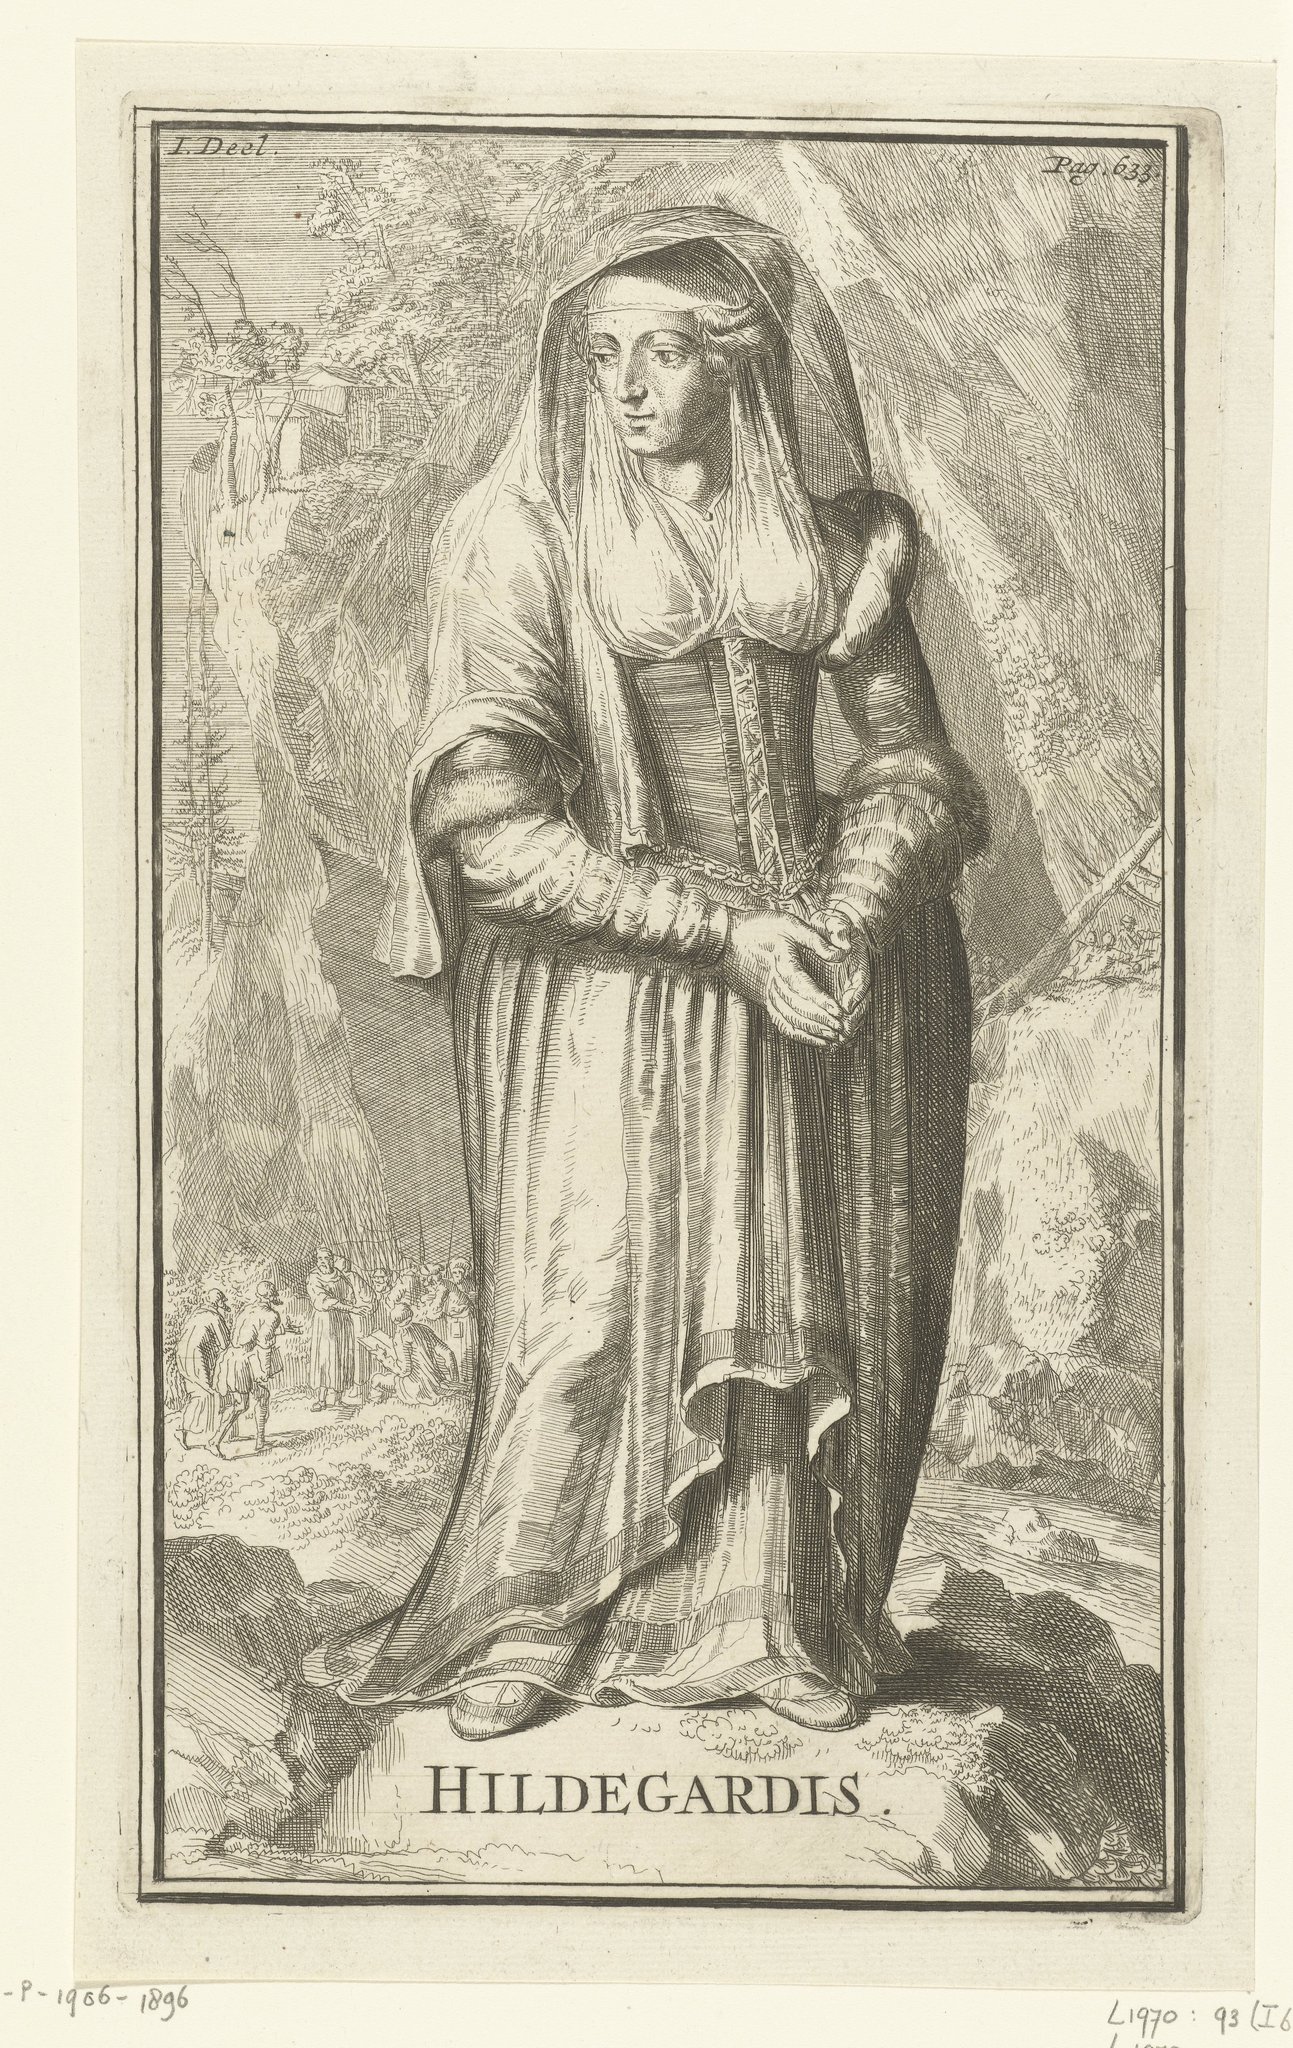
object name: print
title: Historie der Kerken en ketteren (...) tot aan het jaar onses Heeren 1688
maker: romeyn de hooghe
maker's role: draughtsman, goldsmith, painter, print maker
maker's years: 1645-1708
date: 1701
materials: paper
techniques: engraving, etching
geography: netherlands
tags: hildegard van bingen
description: Blad uit: Godfried Arnold, Historie der kerken en ketteren van den beginne des Nieuwen Testaments tot aan het jaar onses Heeren 1688, Amsterdam (Sebastiaan Petzold) 1701, deel 1, p. 633.